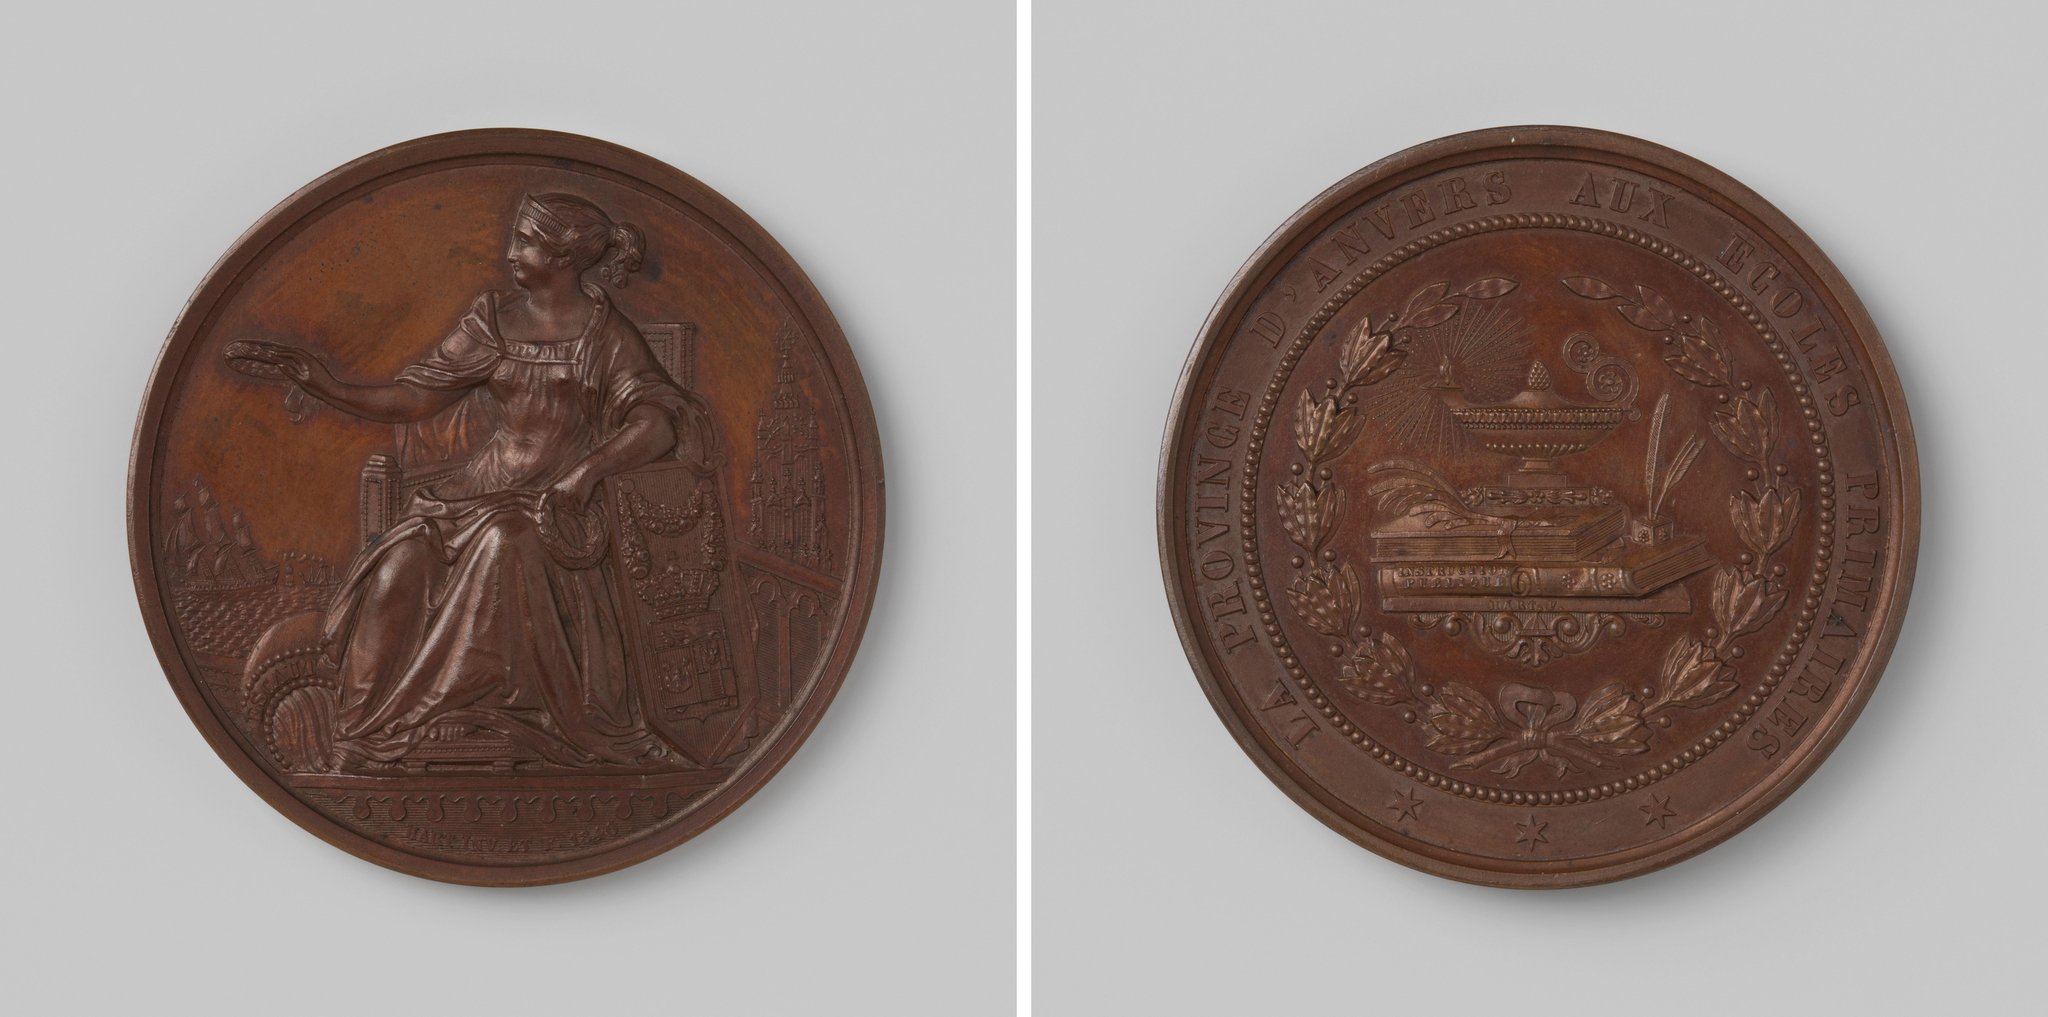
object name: medal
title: Concours van de lagere scholen in de provincie Antwerpen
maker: laurent joseph hart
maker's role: die cutter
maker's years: 1810-1860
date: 1840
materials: bronze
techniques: striking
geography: brussels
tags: antwerp